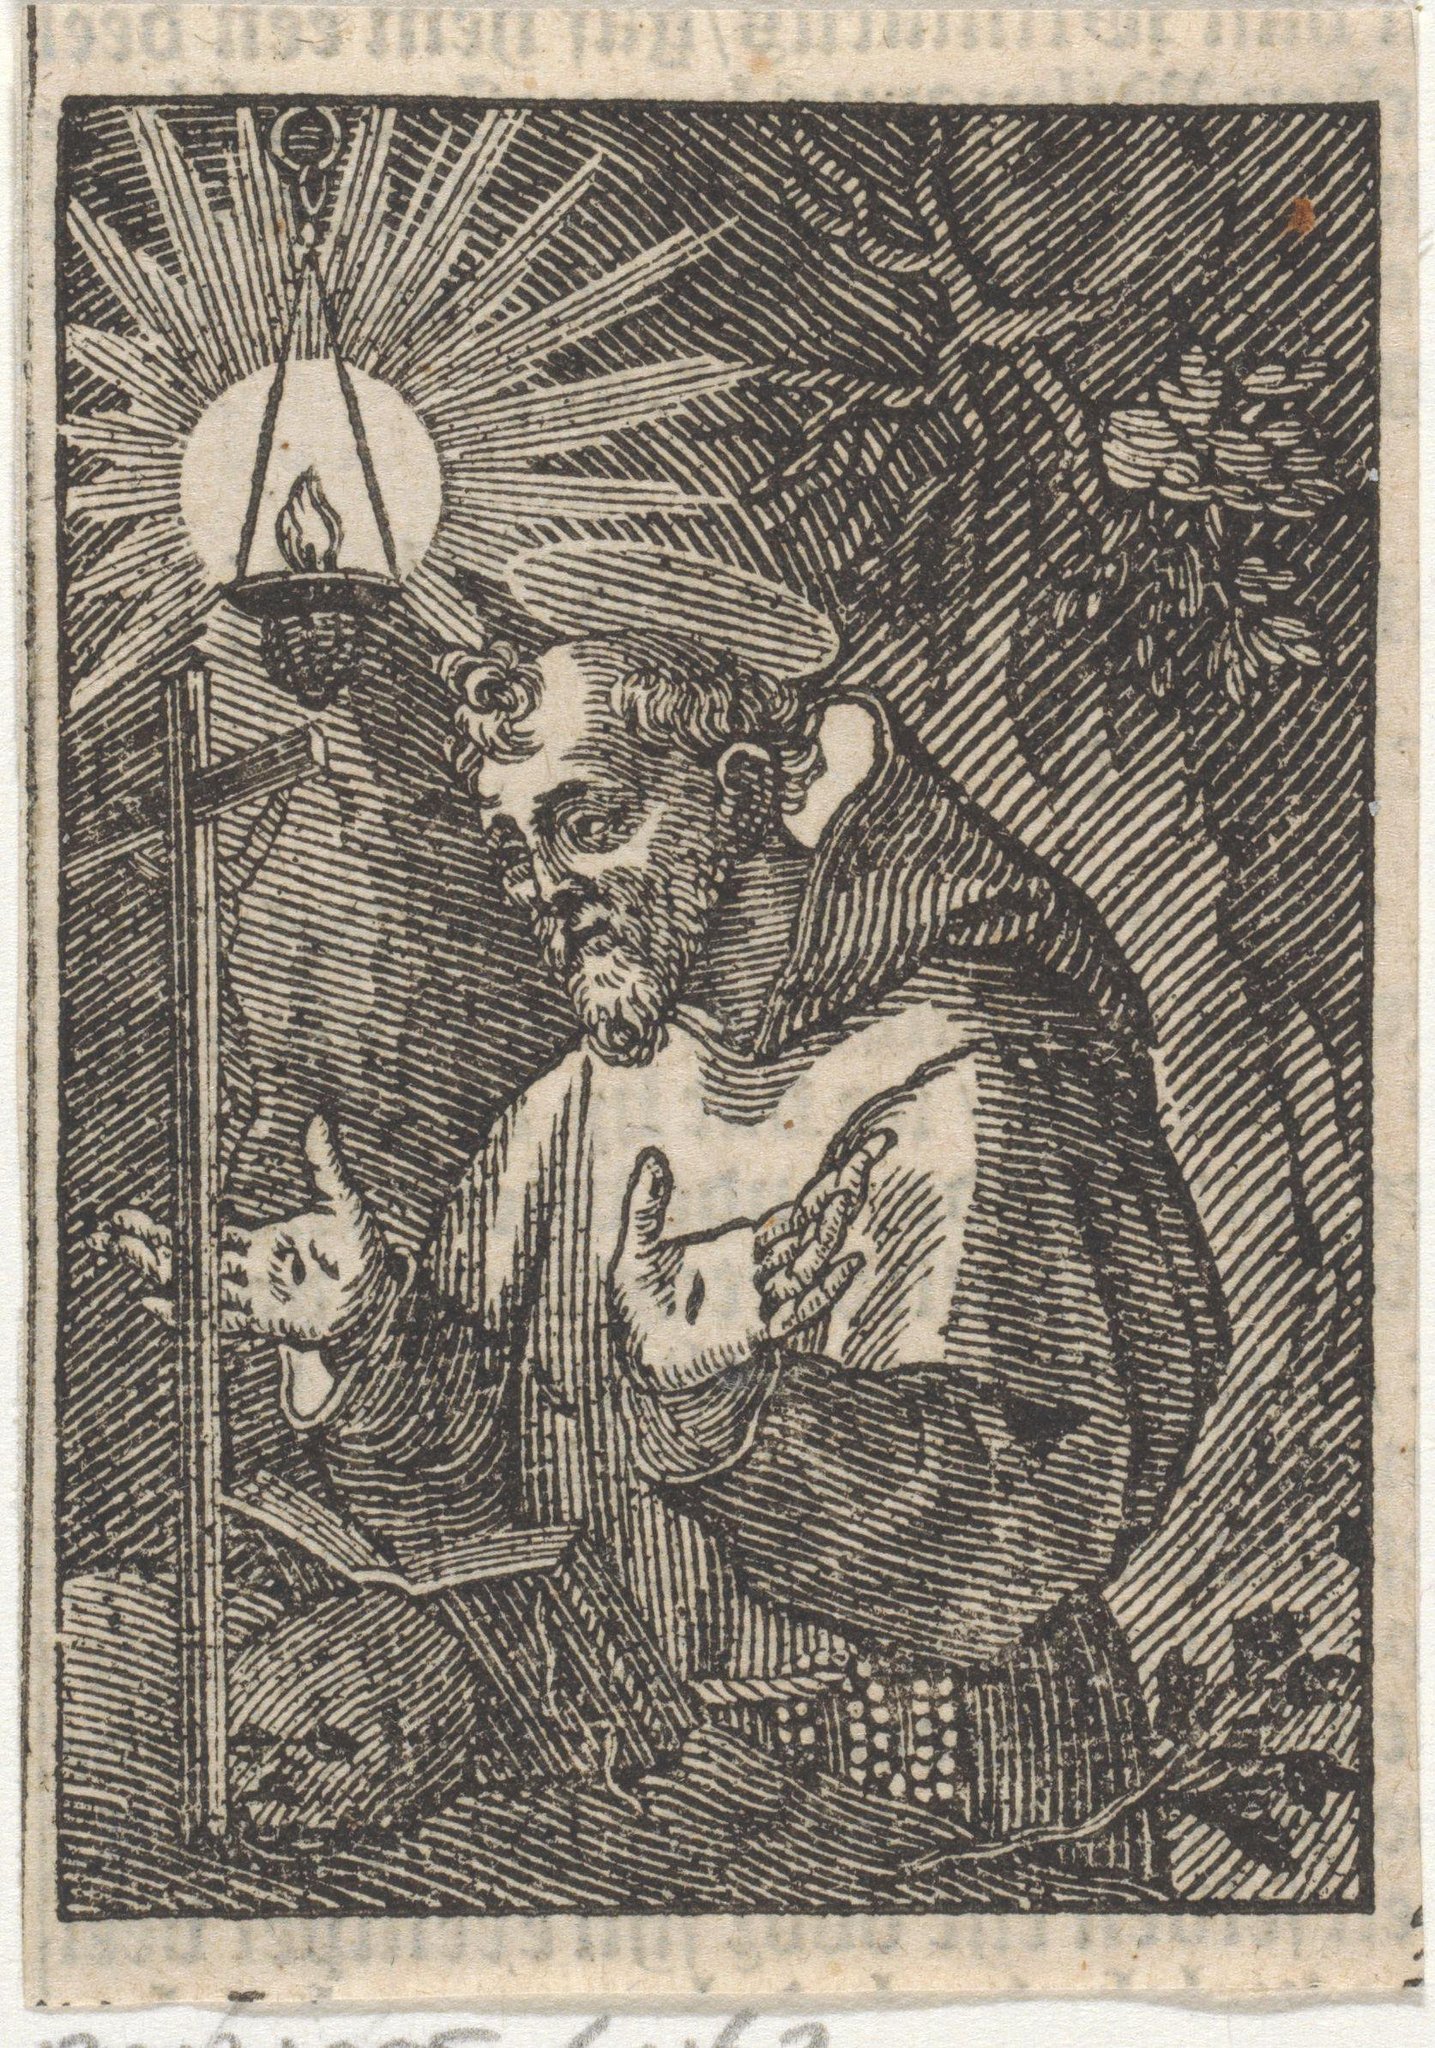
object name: print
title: Heilige met een lantaarn, een kruis en een boek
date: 1648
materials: paper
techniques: letterpress printing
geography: amsterdam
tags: saints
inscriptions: collector's mark: Lugt 2228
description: Prent uit: Sichem, Christoffel van (II). 'tSchat der zielen, dat is: Het geheele leven ons Heeren Iesu Christi. Amsterdam: Pieter Jacobsz. Paets, 1648.